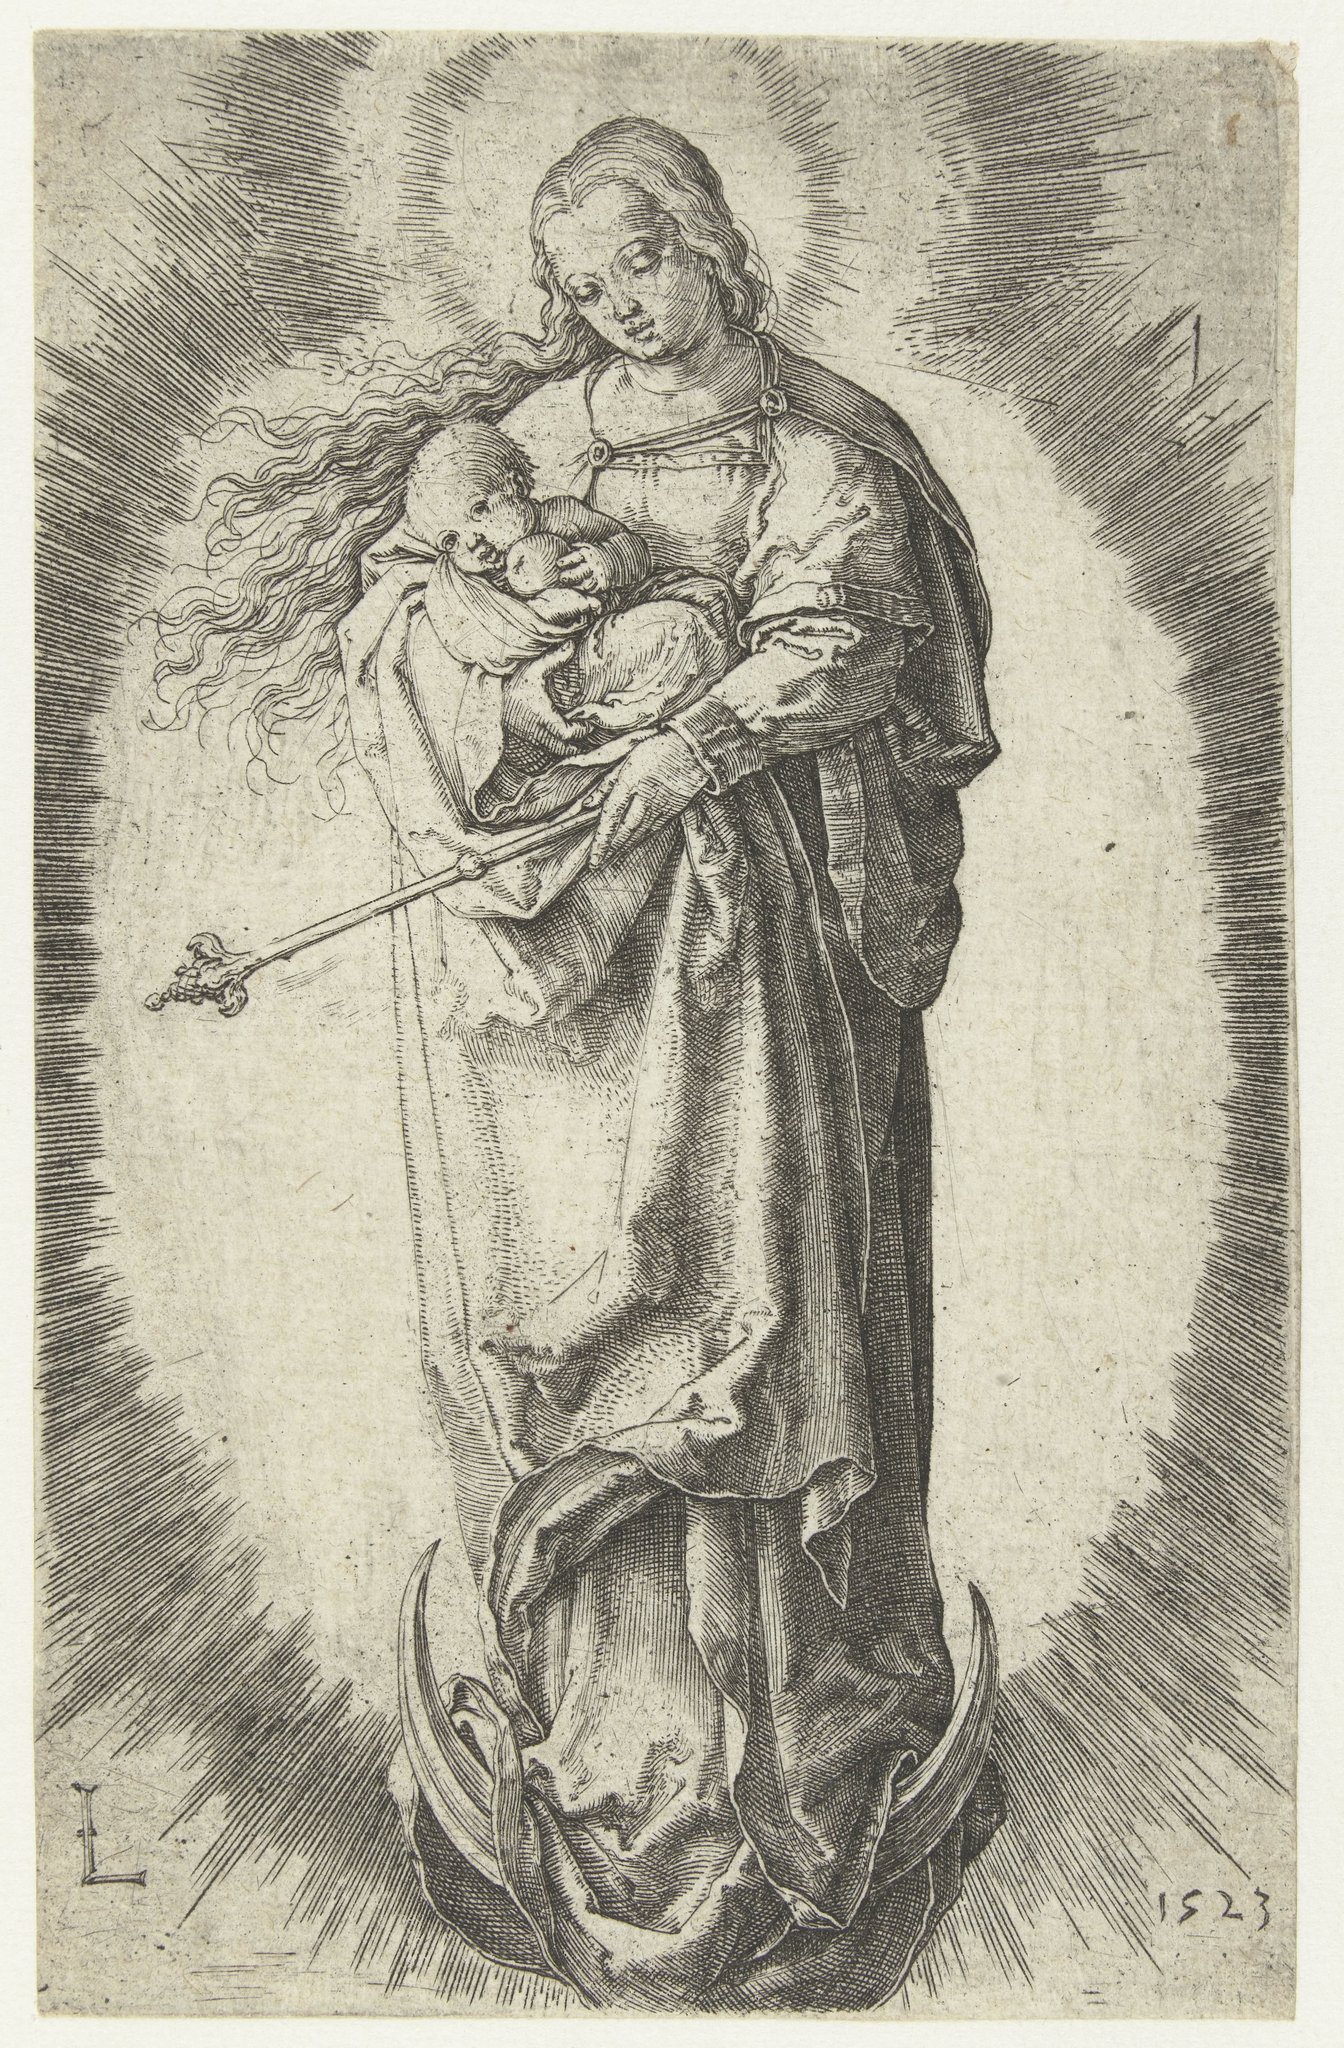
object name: print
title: Madonna op de maansikkel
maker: lucas van leyden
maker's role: draughtsman, painter, print maker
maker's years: 1494-1533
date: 1523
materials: paper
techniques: engraving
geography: low countries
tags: 'immaculata', 'purisima': mary, usually standing on a crescent moon, descending from heaven, exempt from original sin (sometimes trampling serpent)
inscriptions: collector's mark: Lugt 2228a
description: Maria met Christuskind op de arm, staf in andere hand, staand op een maansikkel.